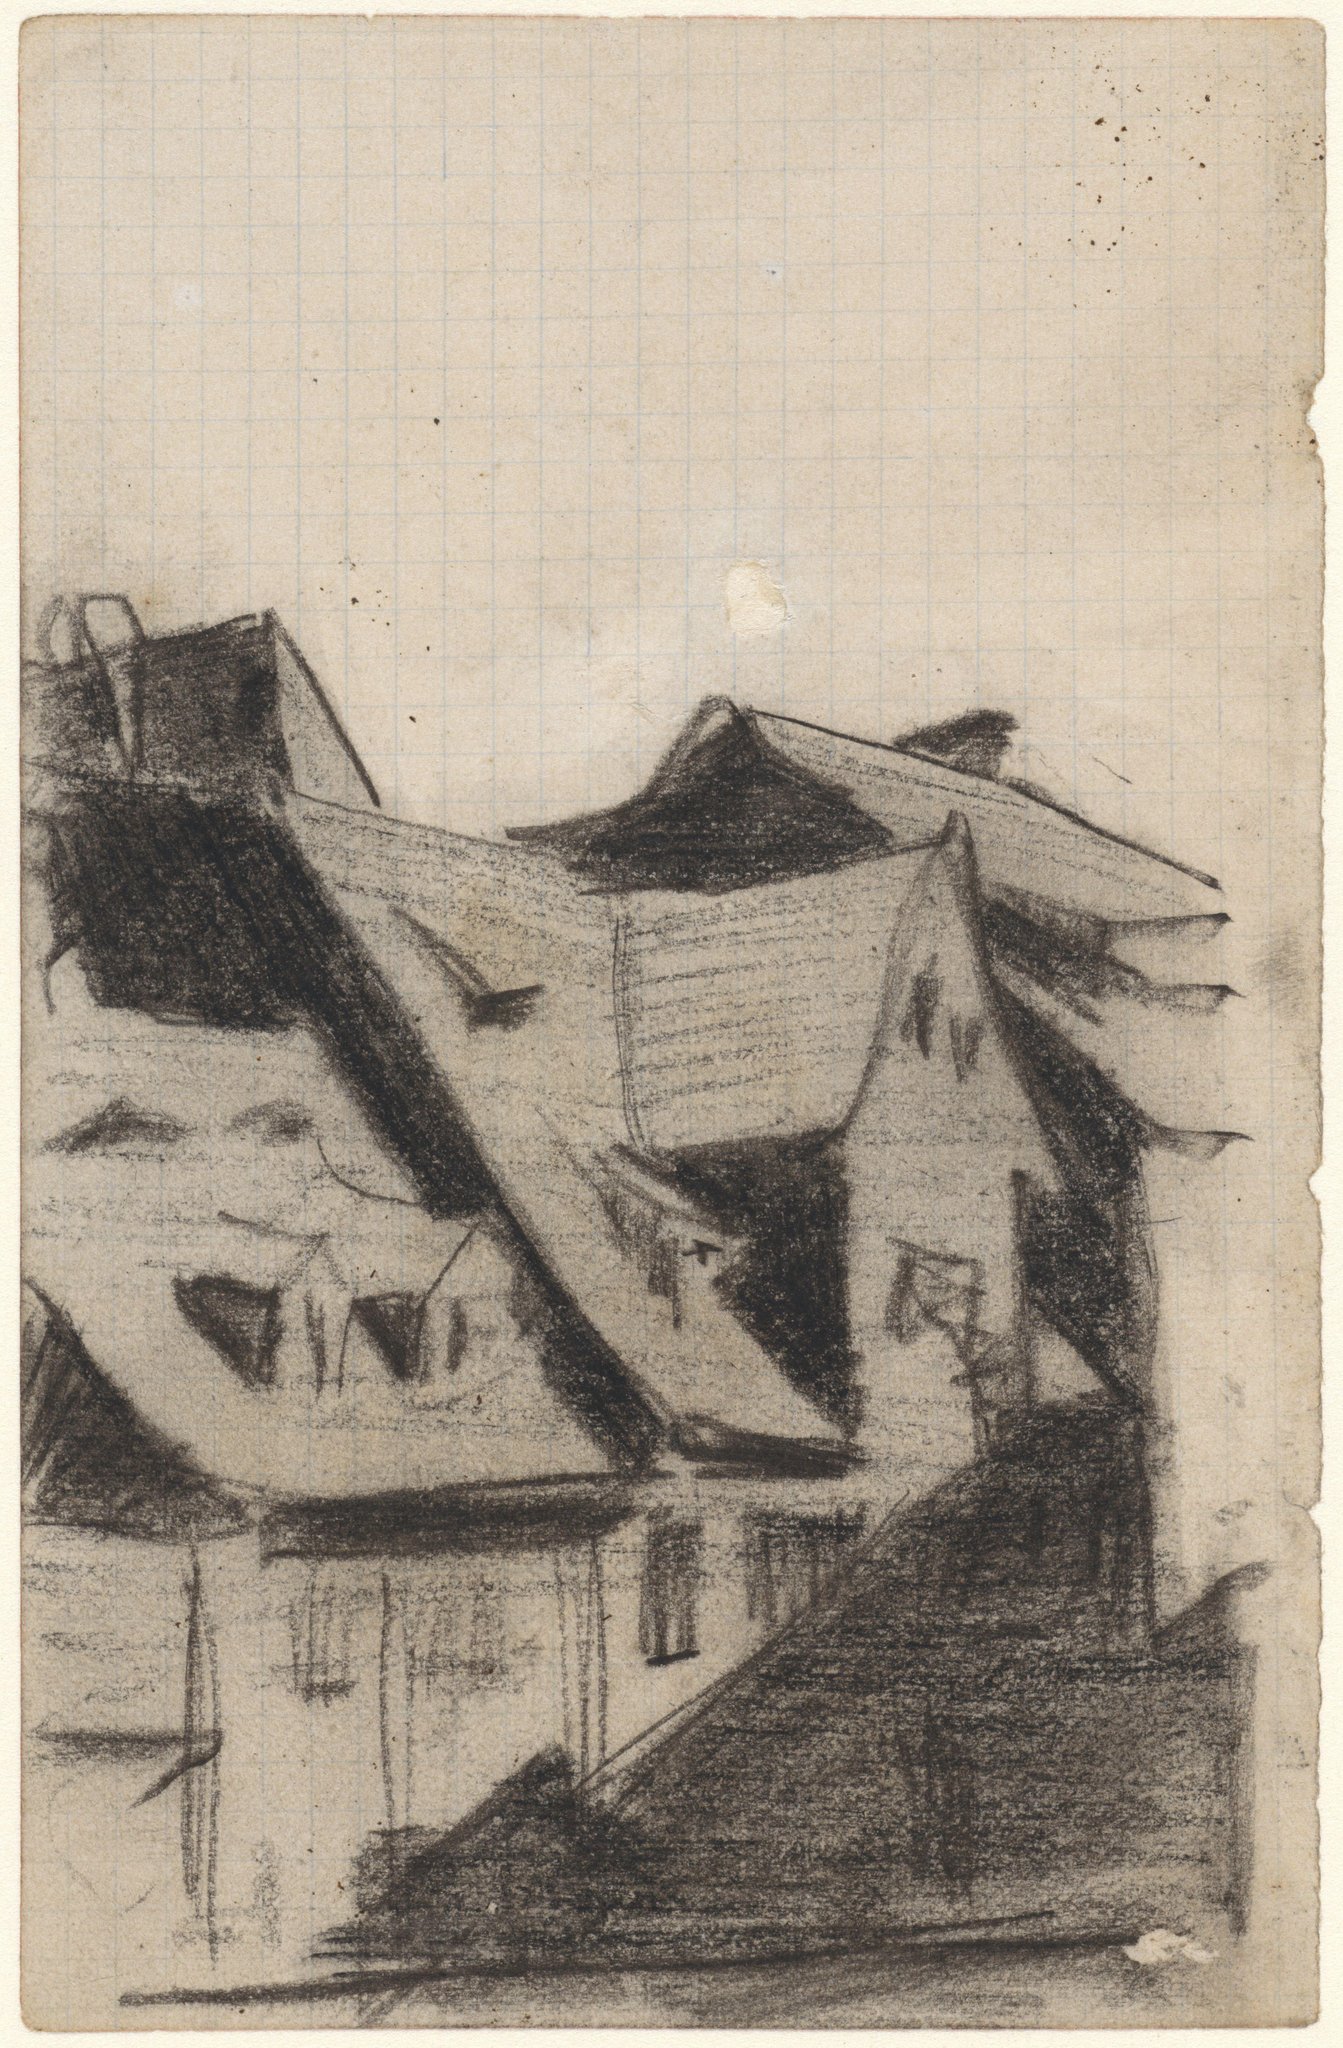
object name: drawing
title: Huizen te Dresden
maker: theo nieuwenhuis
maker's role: designer, draughtsman, print maker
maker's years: 1866-1951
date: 1888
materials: chalk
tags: urban housing, street, germany